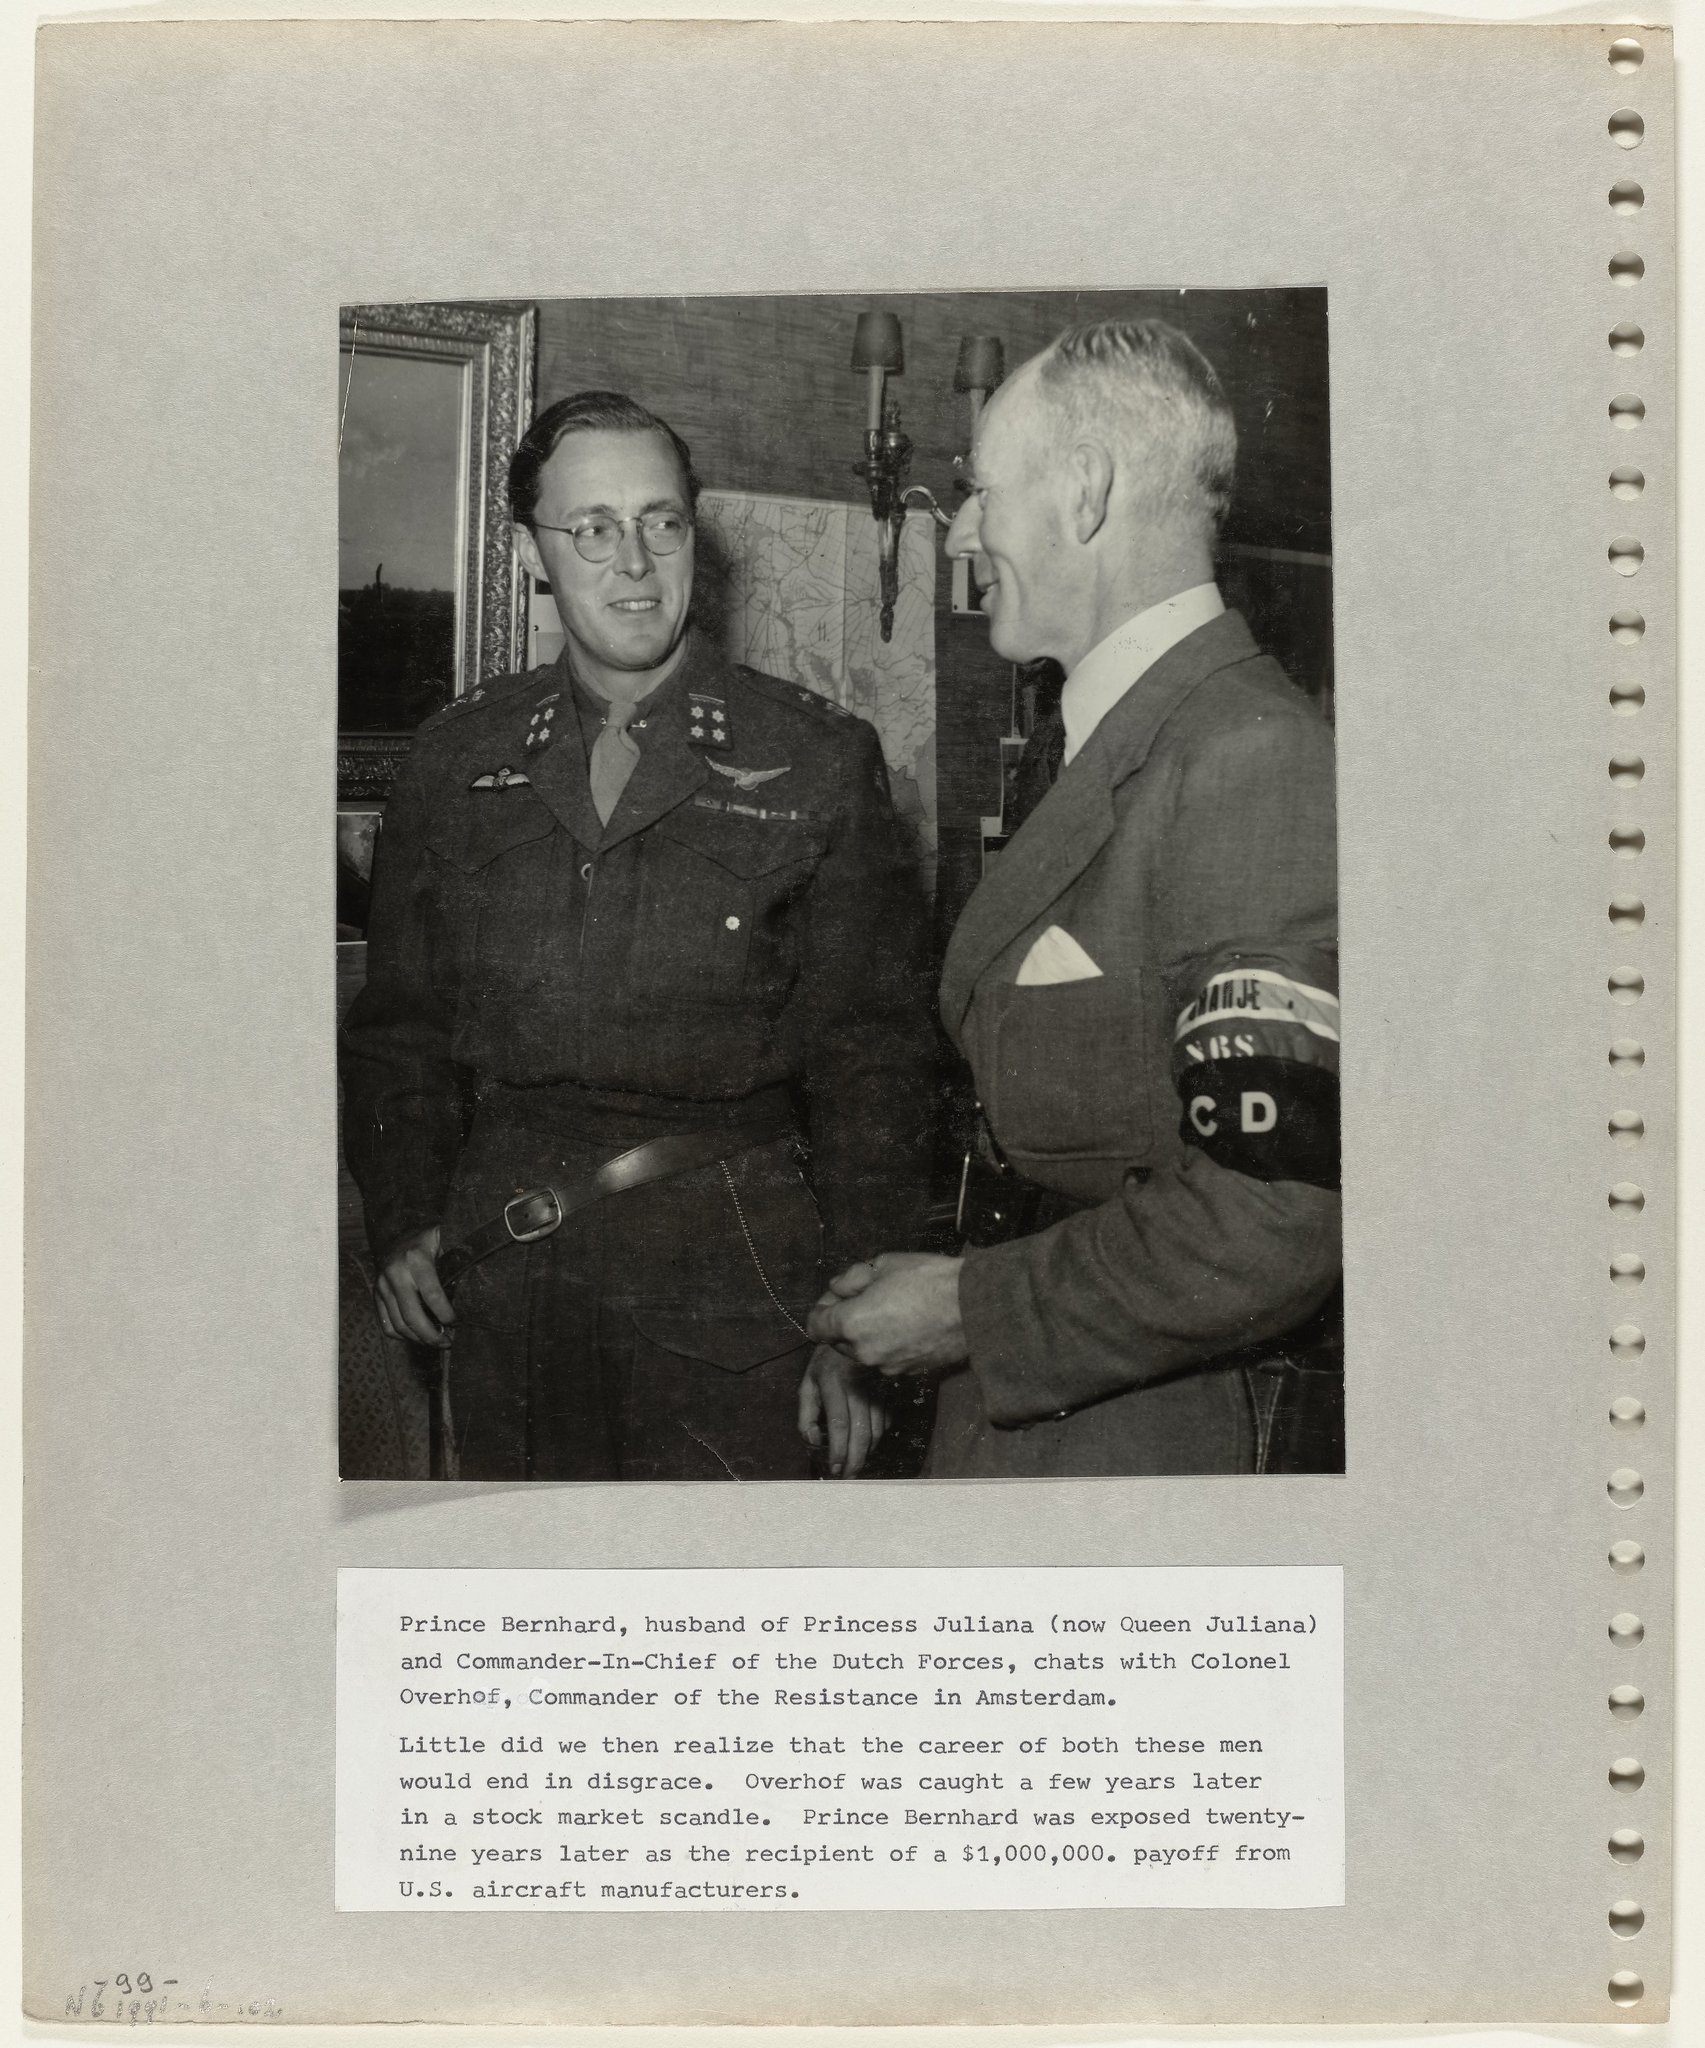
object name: album leaf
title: Prins Bernhard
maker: Anonymous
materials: paper, plastic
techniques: photography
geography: amsterdam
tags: utrecht, bernhard (prins der nederlanden), tonny van renterghem, fritz kahlenberg, underground movement, partisans, netherlands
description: Prins Bernhard, in militair uniform in gesprek met een van de leiders van het verzet, Kolonel Overhof. Om zijn arm de mouwband van de NBS en de band met CD = Command Dutch Forces.